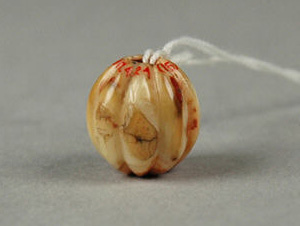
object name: ojime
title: Ojime in the Shape of a Melon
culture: japanese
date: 1801-1900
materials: stone